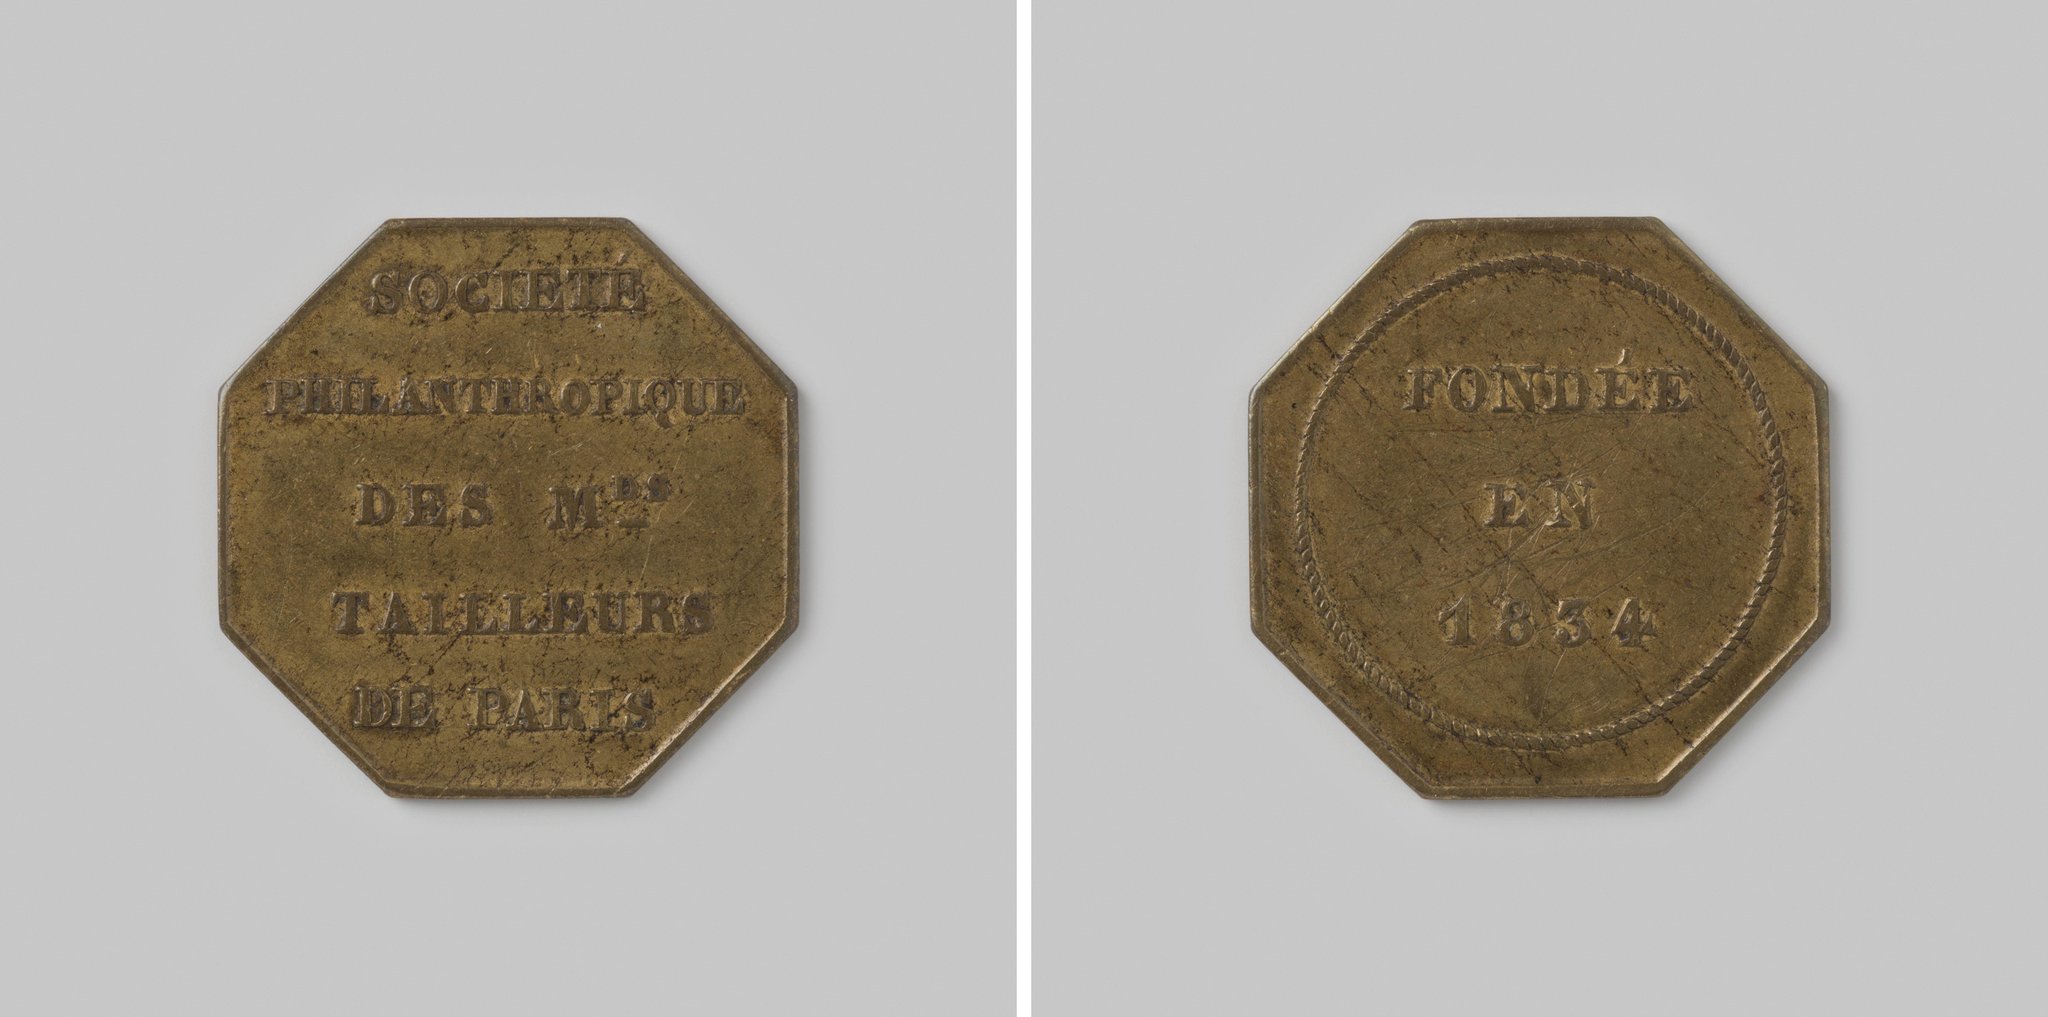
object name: history medal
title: Societé Philantropique des Mds Tailleurs de Paris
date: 1870-1930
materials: brass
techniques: striking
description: Achthoekige messing penning, op de voorzijde vijf regels tekst, op de keerzijde drie regels tekst binnen een parelcirkel.